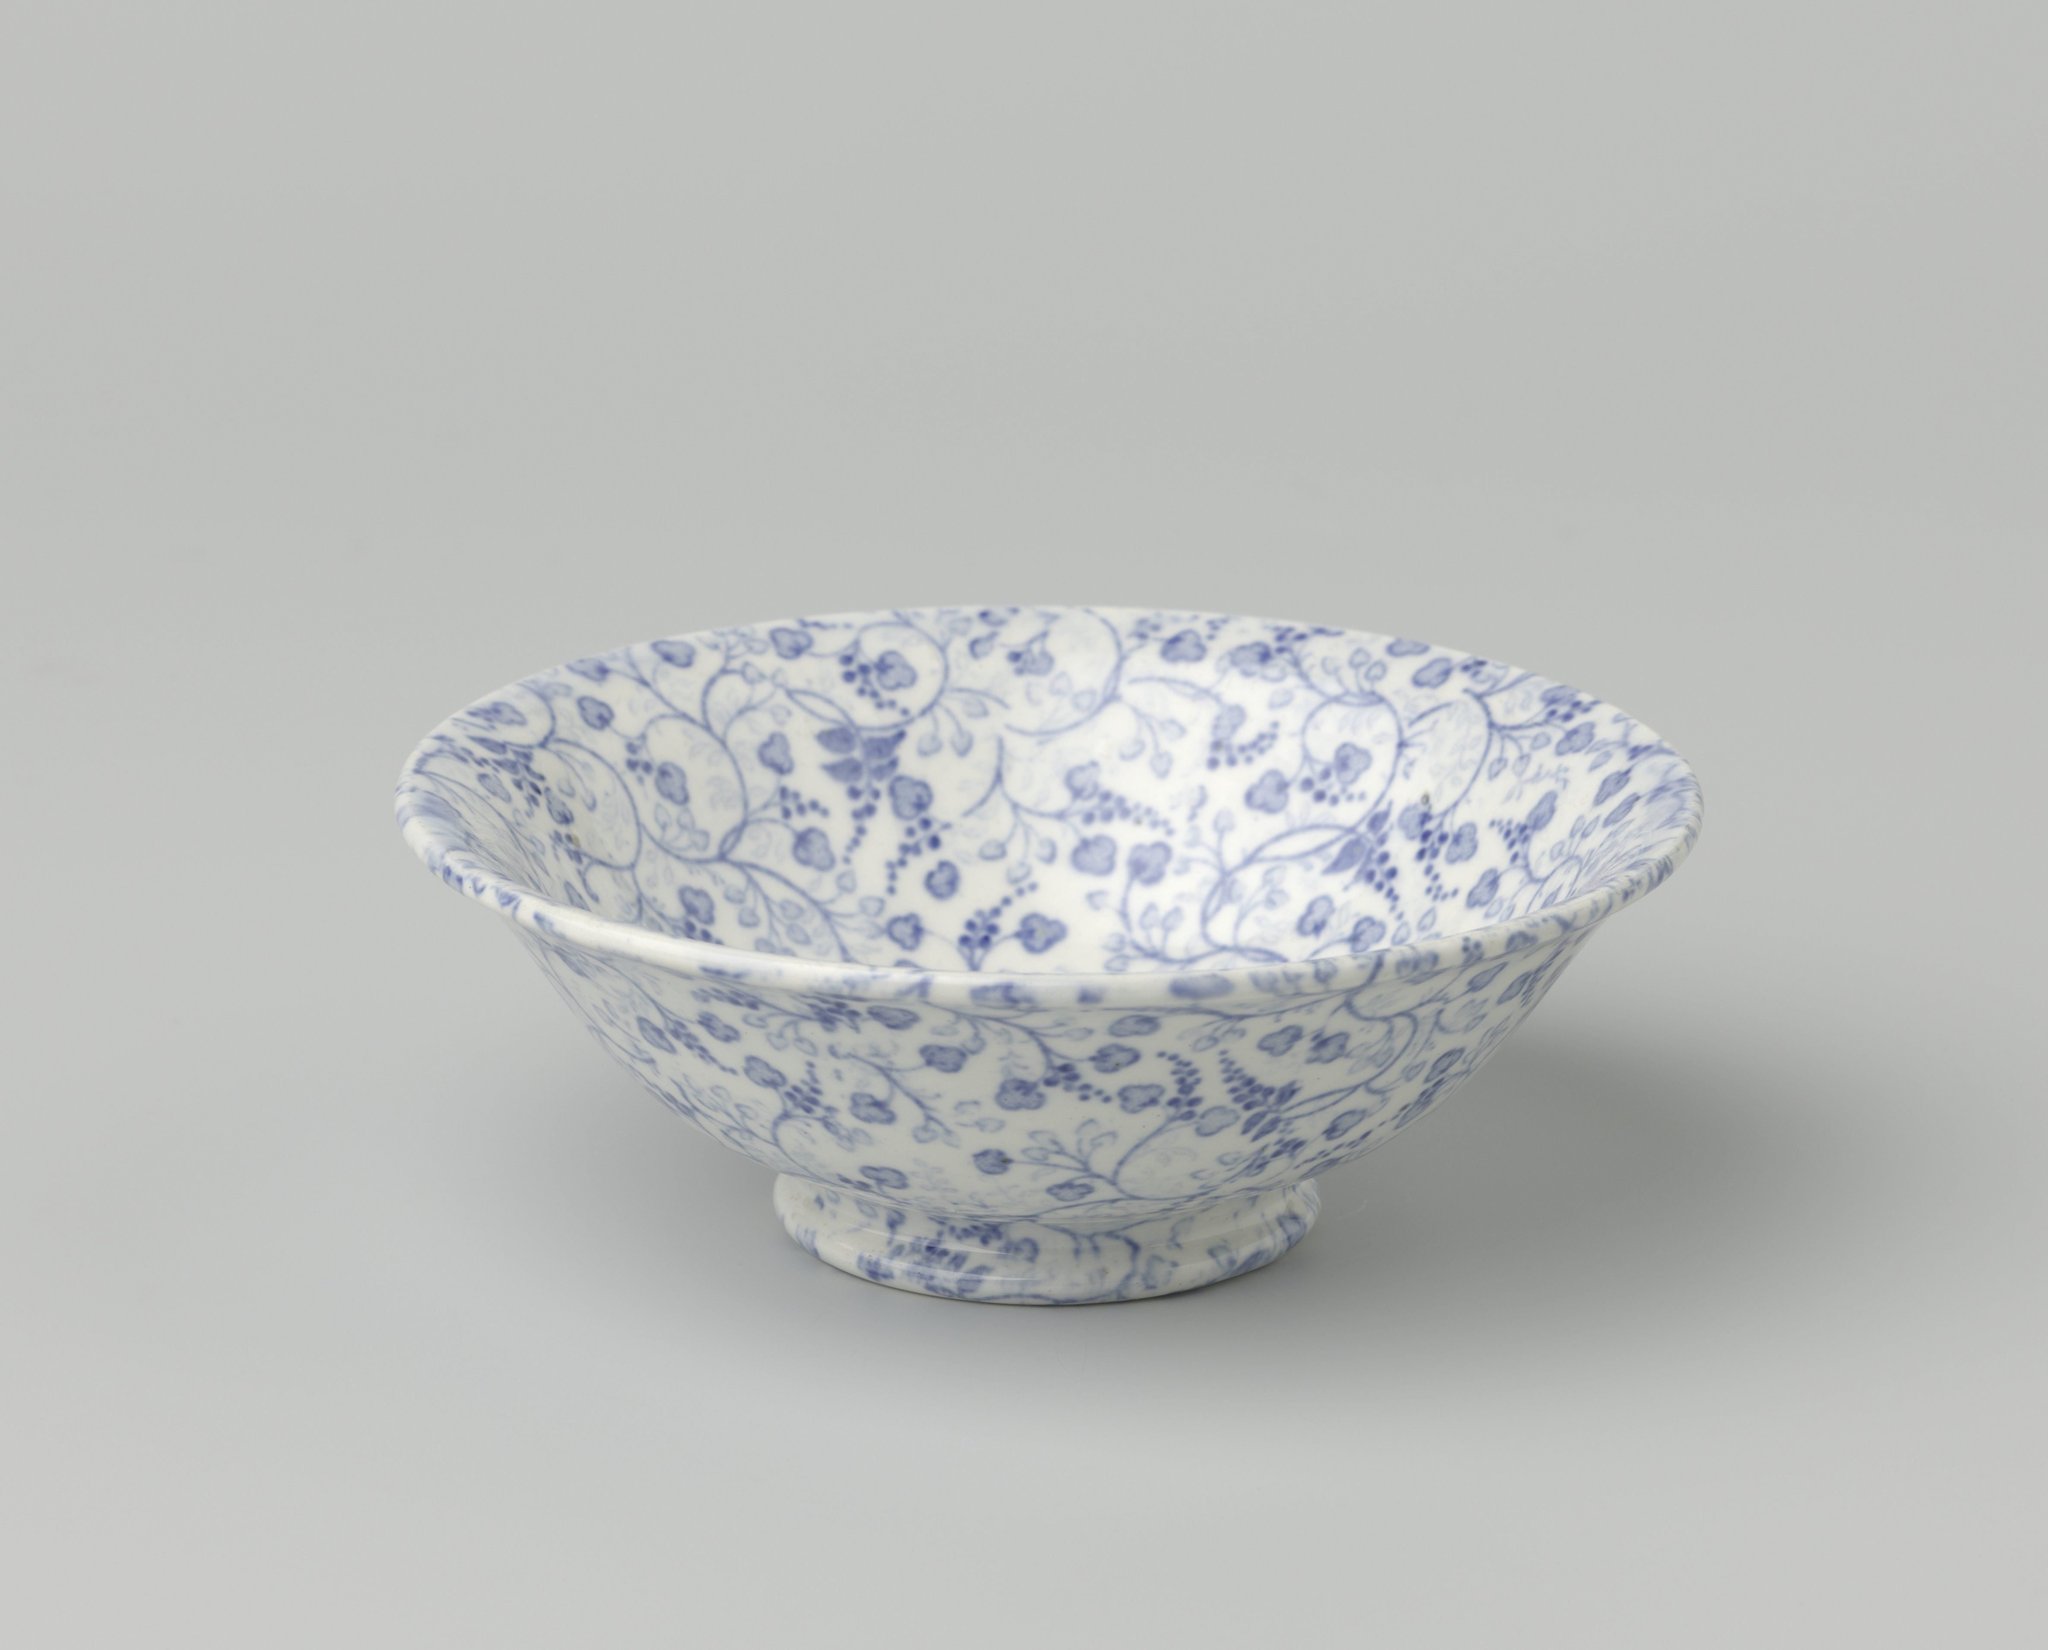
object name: bowl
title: Kom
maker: petrus regout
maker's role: plateelbakker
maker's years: 1801-1879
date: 1867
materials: creamware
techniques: transfer decoration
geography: maastricht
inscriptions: check stamp: ‘PR 8’, mark: ‘PARSEME No 3’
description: Kom van aardewerk, met blauw doorlopend bloemendecor, behorend tot een kinderservies.